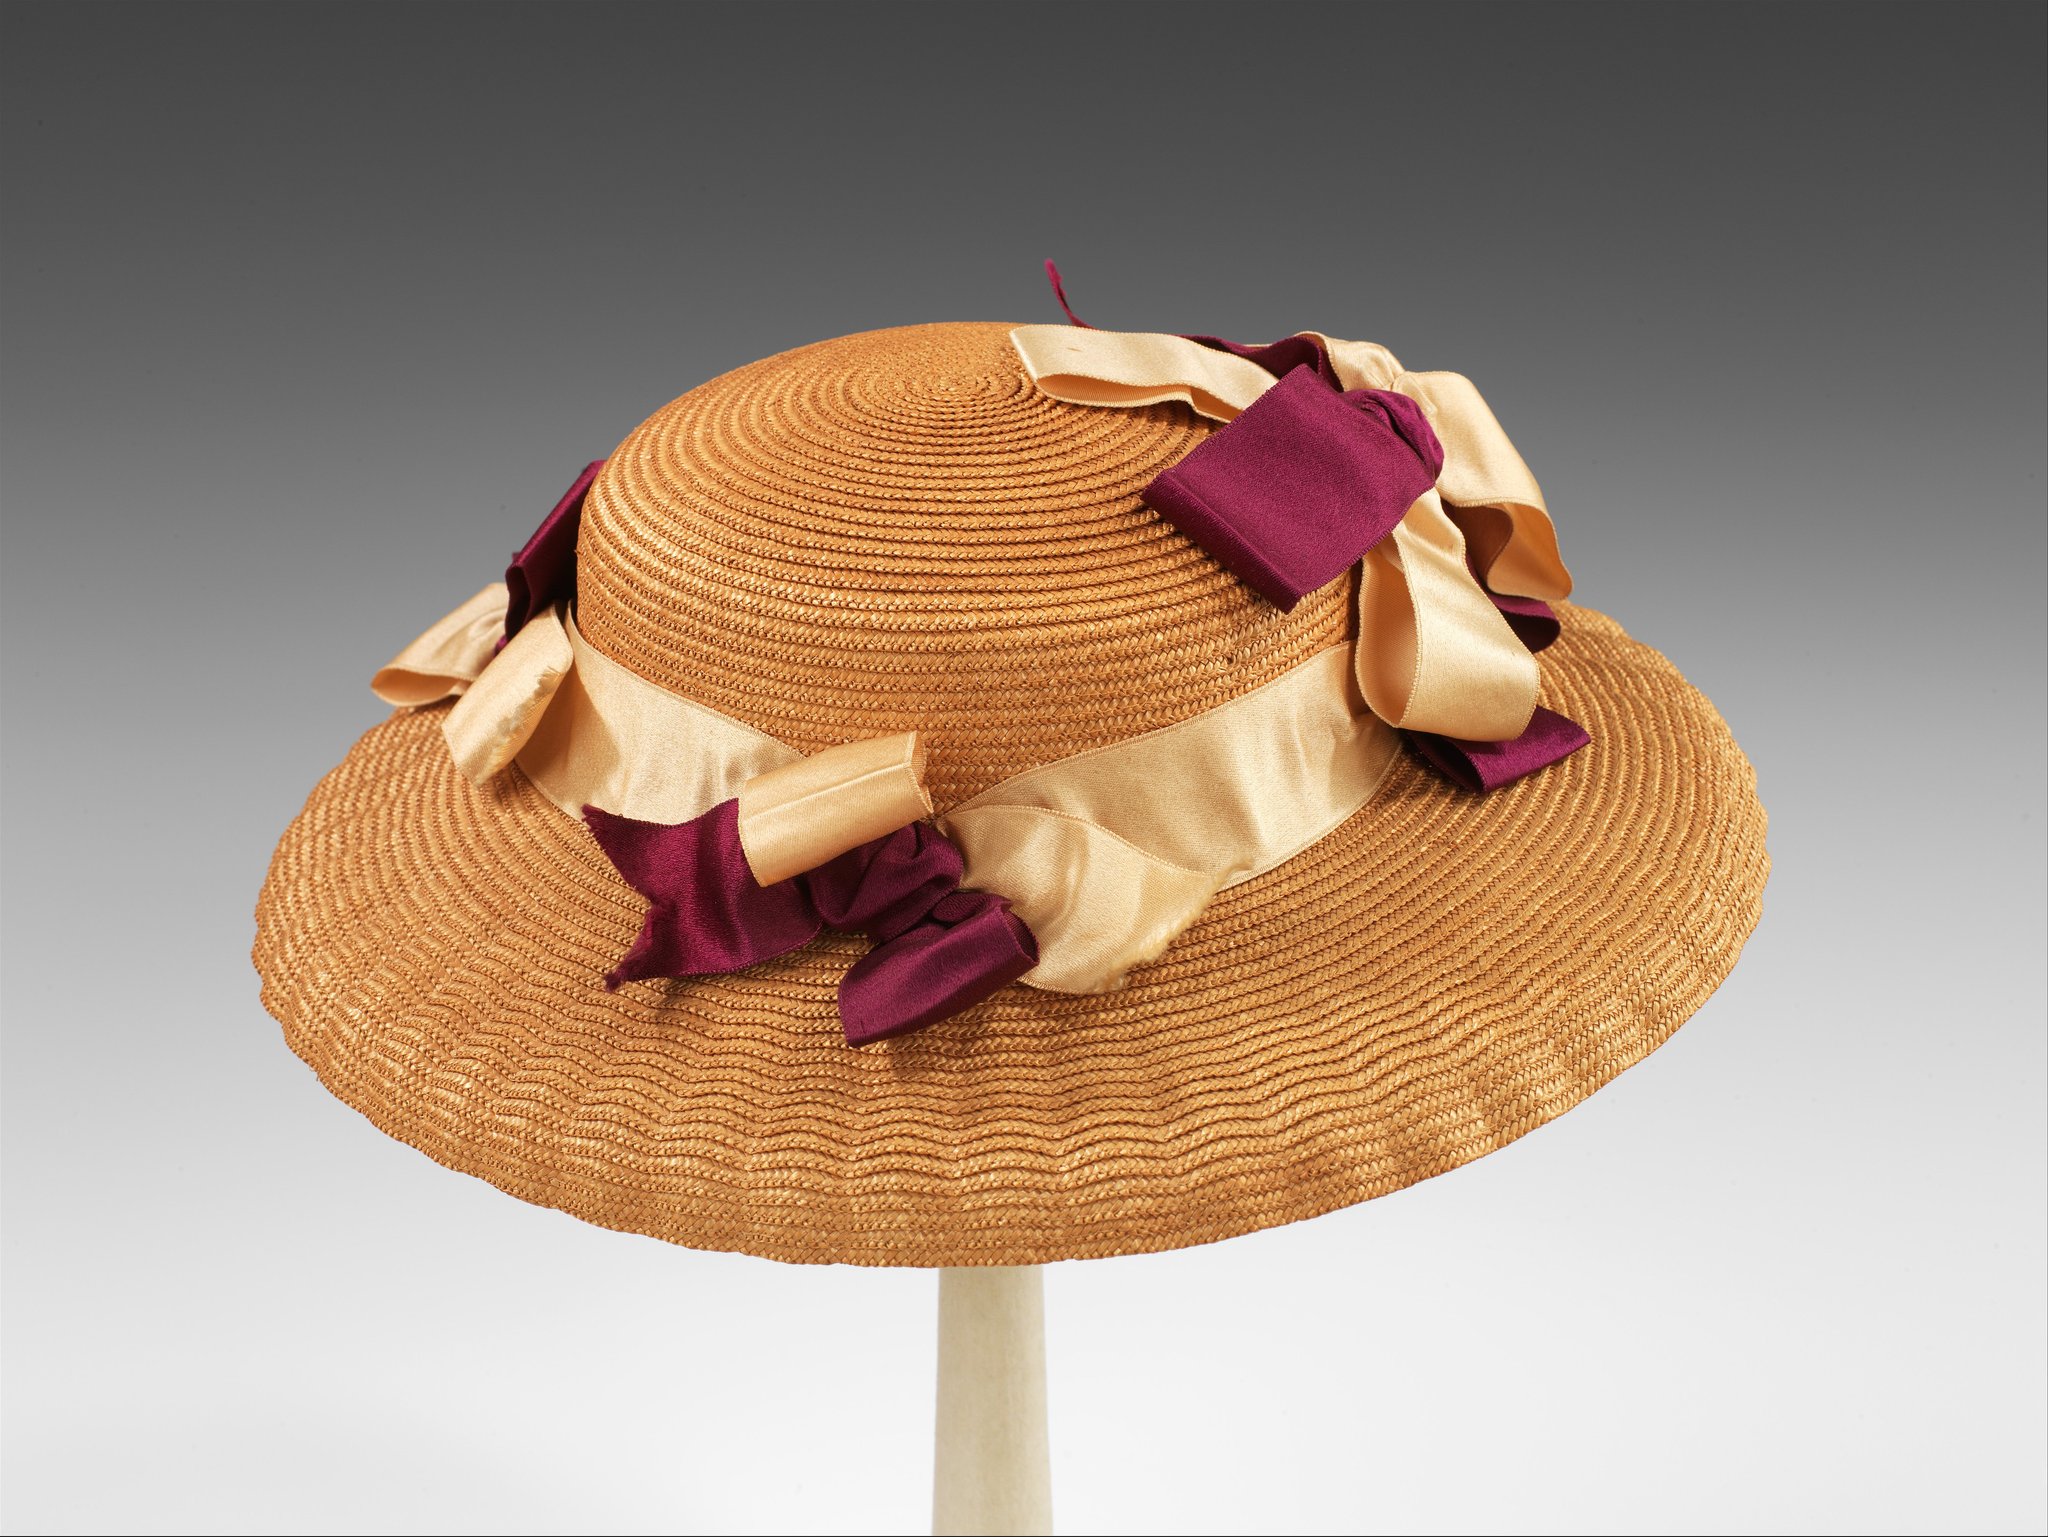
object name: sailor hat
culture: american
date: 1883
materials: silk, fiber